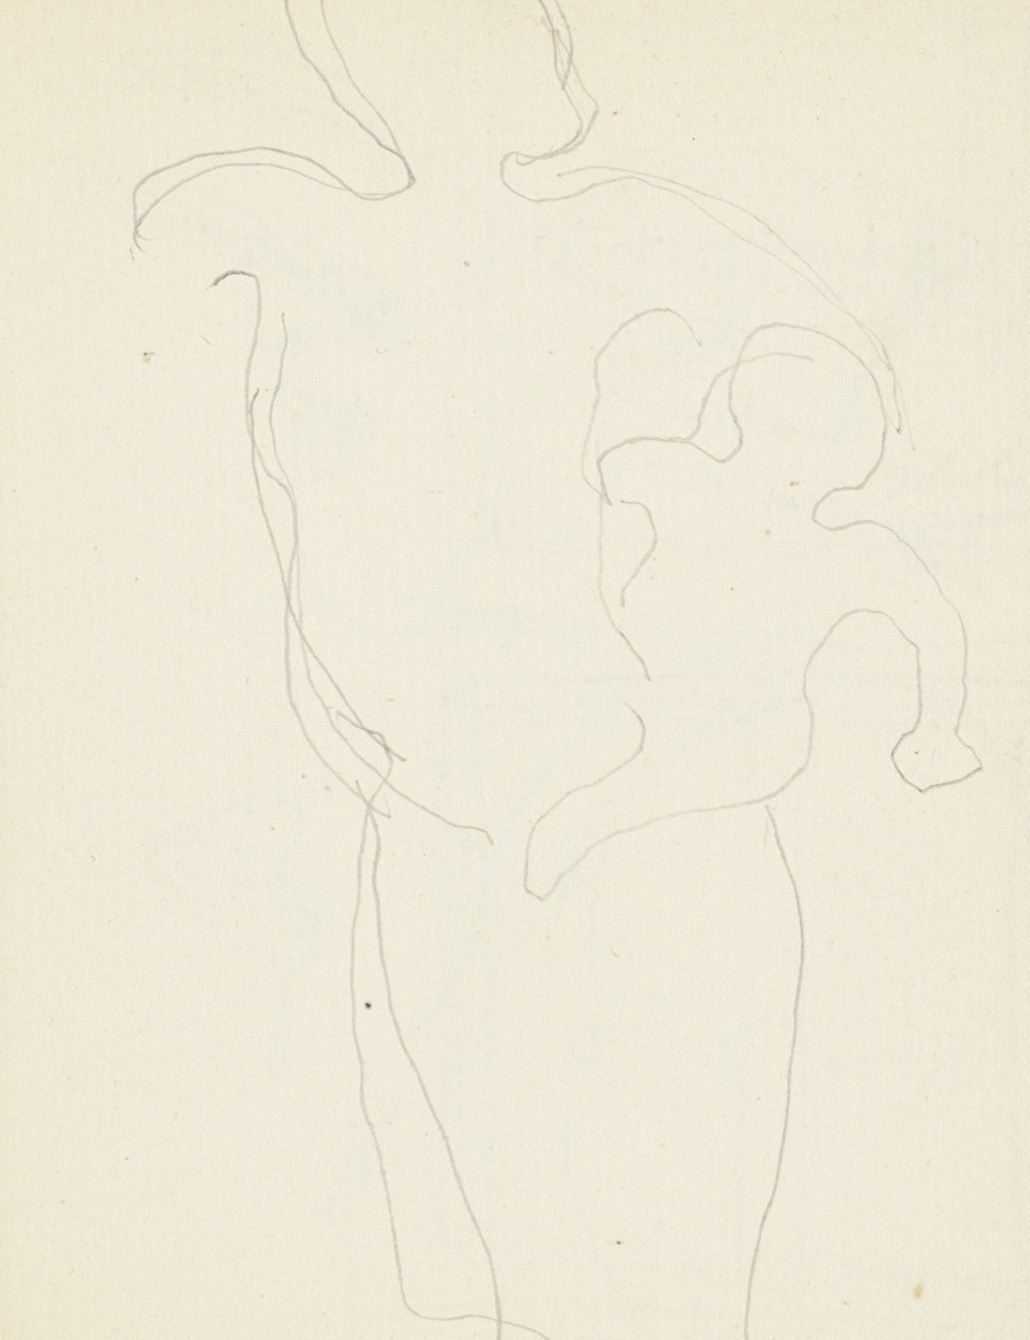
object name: sketchbook leaf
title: Afrikaanse vrouw met een kind op de heup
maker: reijer stolk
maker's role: draughtsman, print maker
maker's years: 1896-1945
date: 1916-1945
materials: paper, pencil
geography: africa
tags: carrying a child on the hip, astride, africans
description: Blad 34 recto uit een schetsboek met 60 bladen.